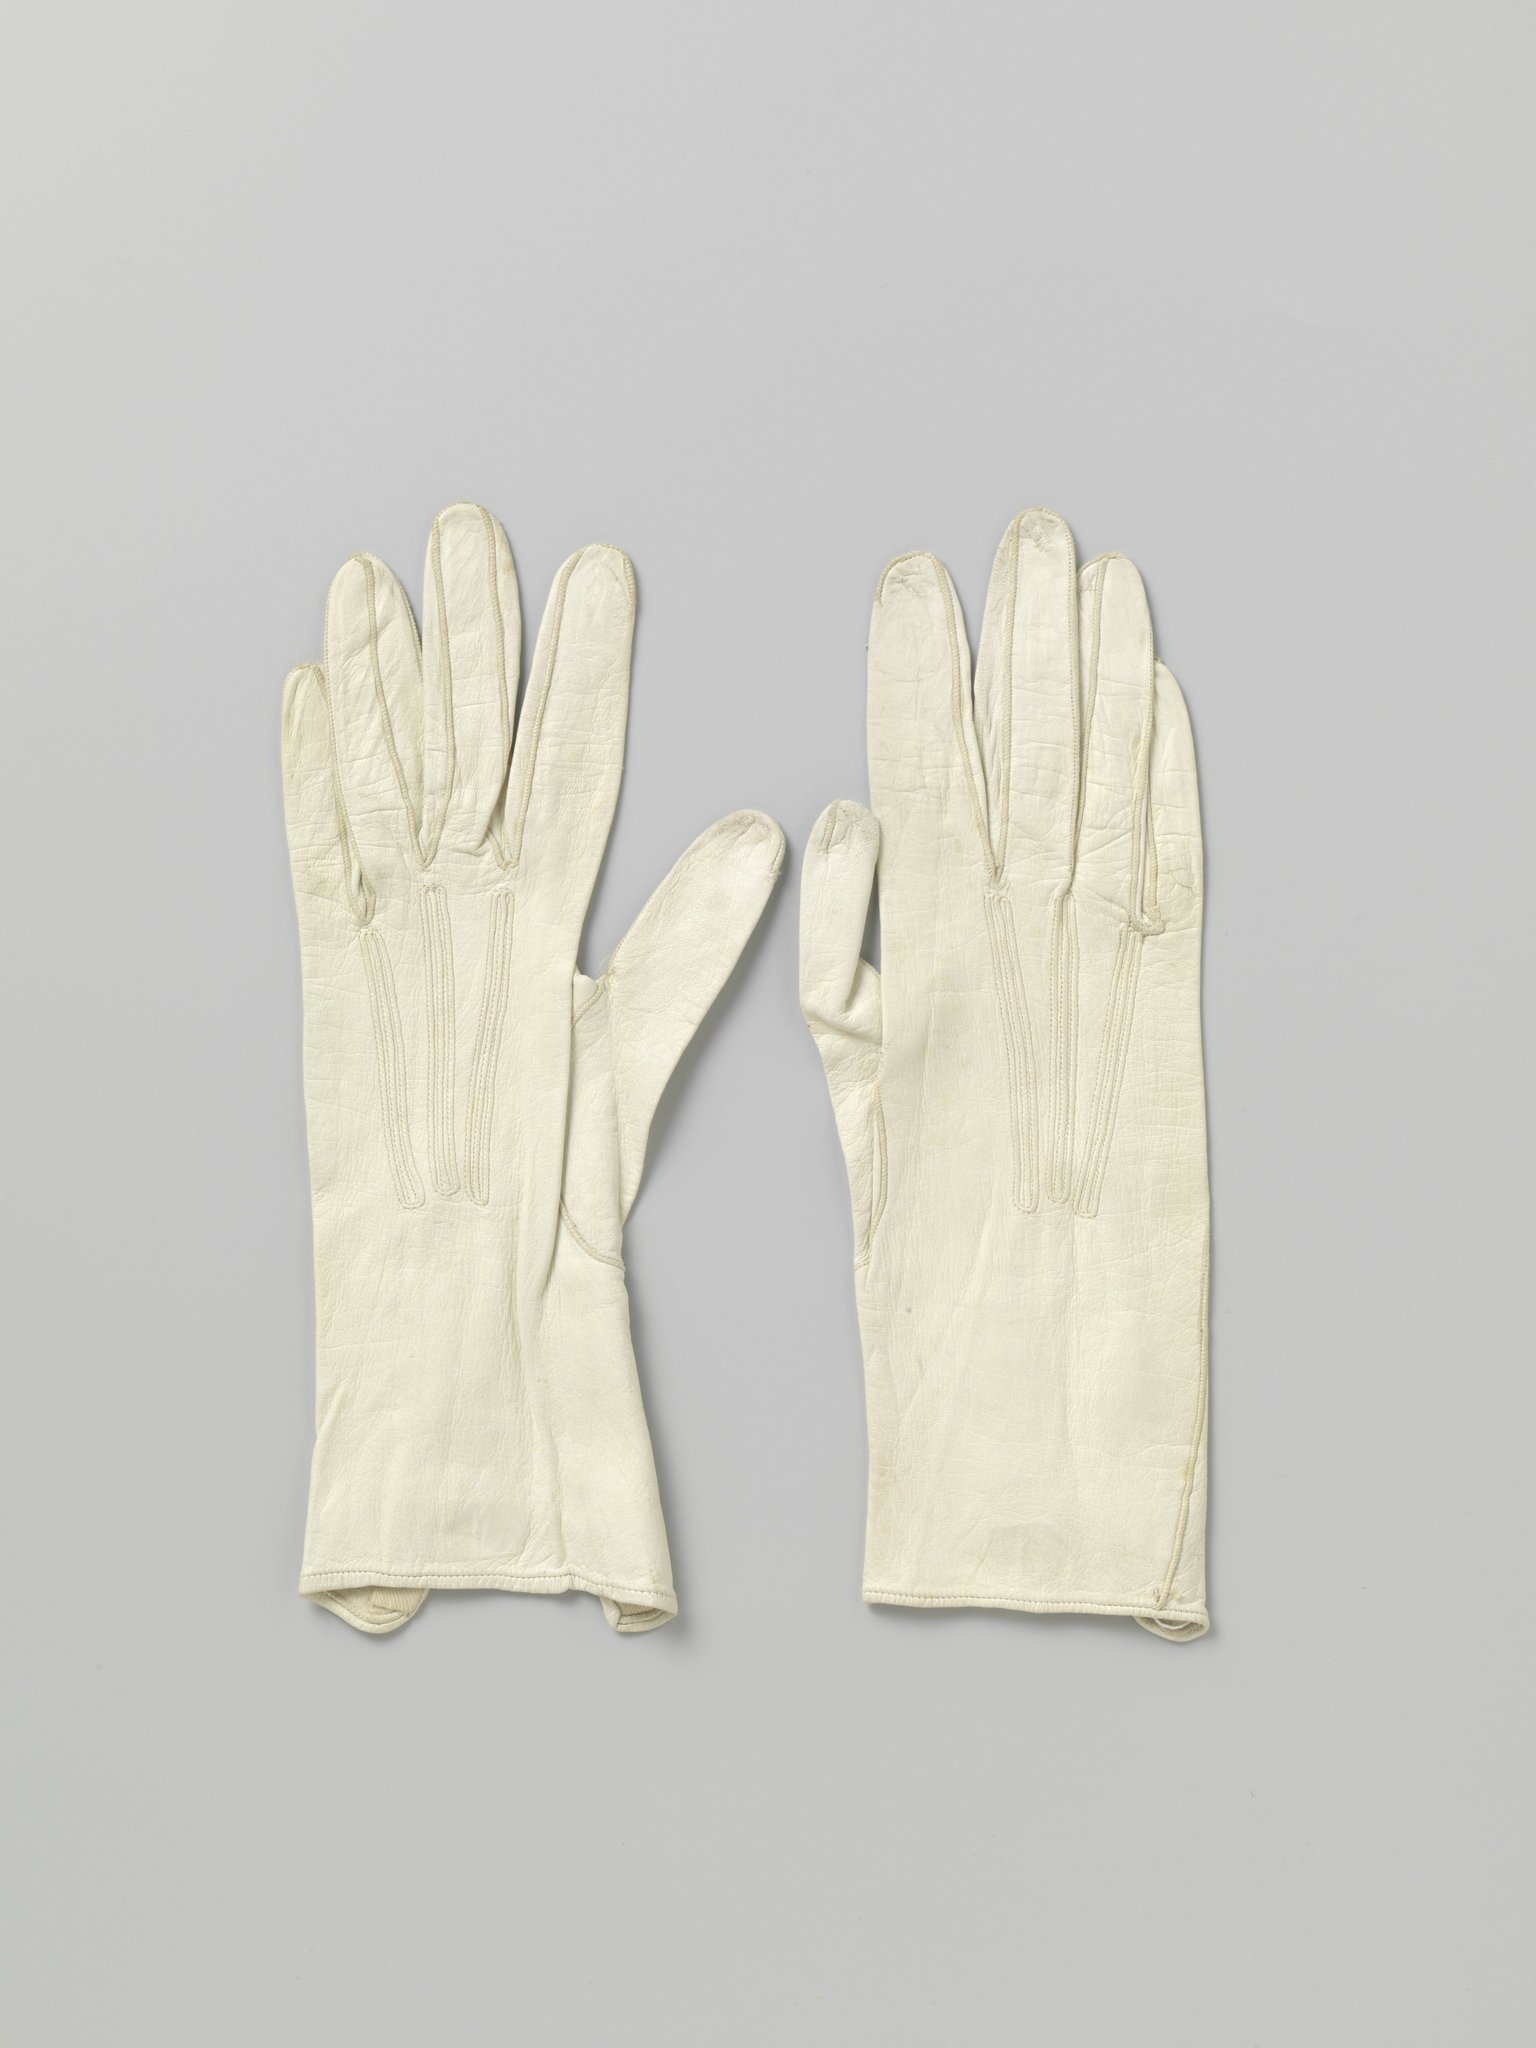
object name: glove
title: Handschoen van leer met twee parelmoer drukknopen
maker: Anonymous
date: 1900-1950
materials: leather, mother of pearl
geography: netherlands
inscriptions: : ‘cijfers’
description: Rechter handschoen van leer met twee parelmoer drukknopen en op de rug drie uitstralende koorden.